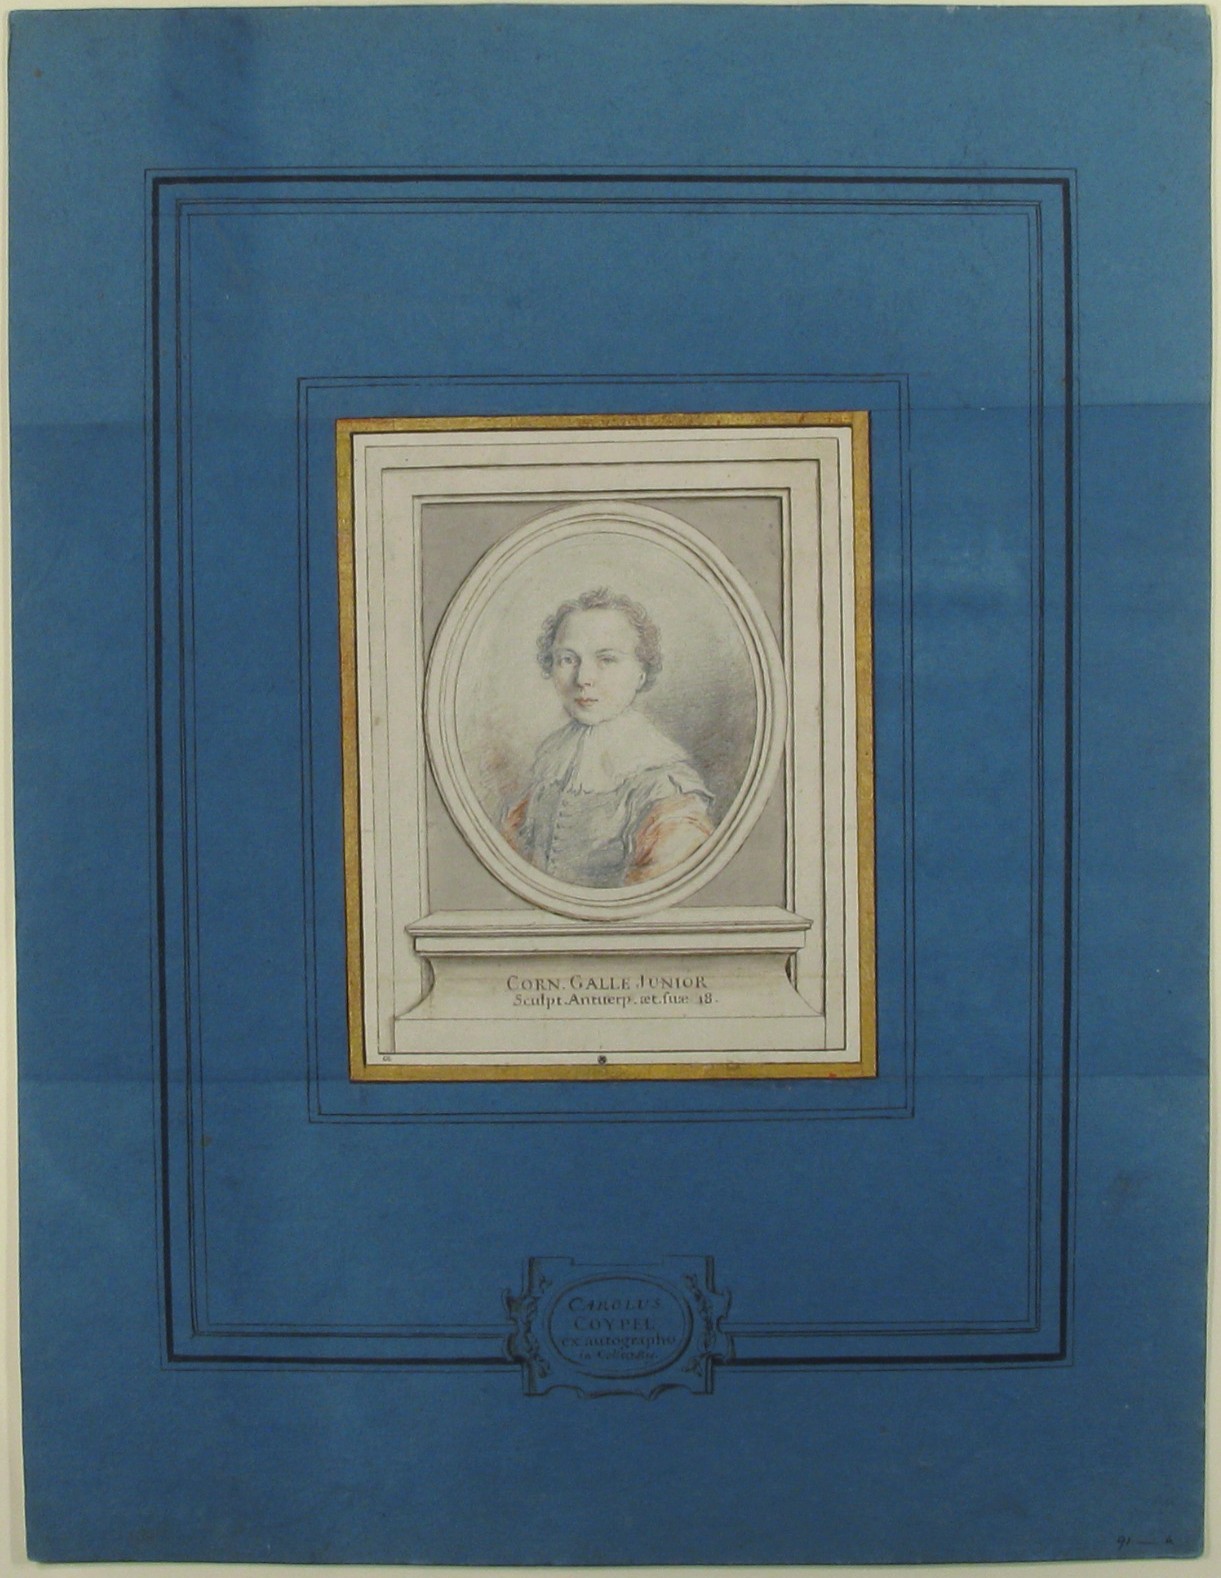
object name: drawing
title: Portrait of Cornelius Galle, Jr.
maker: charles antoine coypel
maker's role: artist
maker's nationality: french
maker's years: 1694-1752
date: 1701-1800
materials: chalk, graphite, ink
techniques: brush, pen, wash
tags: men,portraits